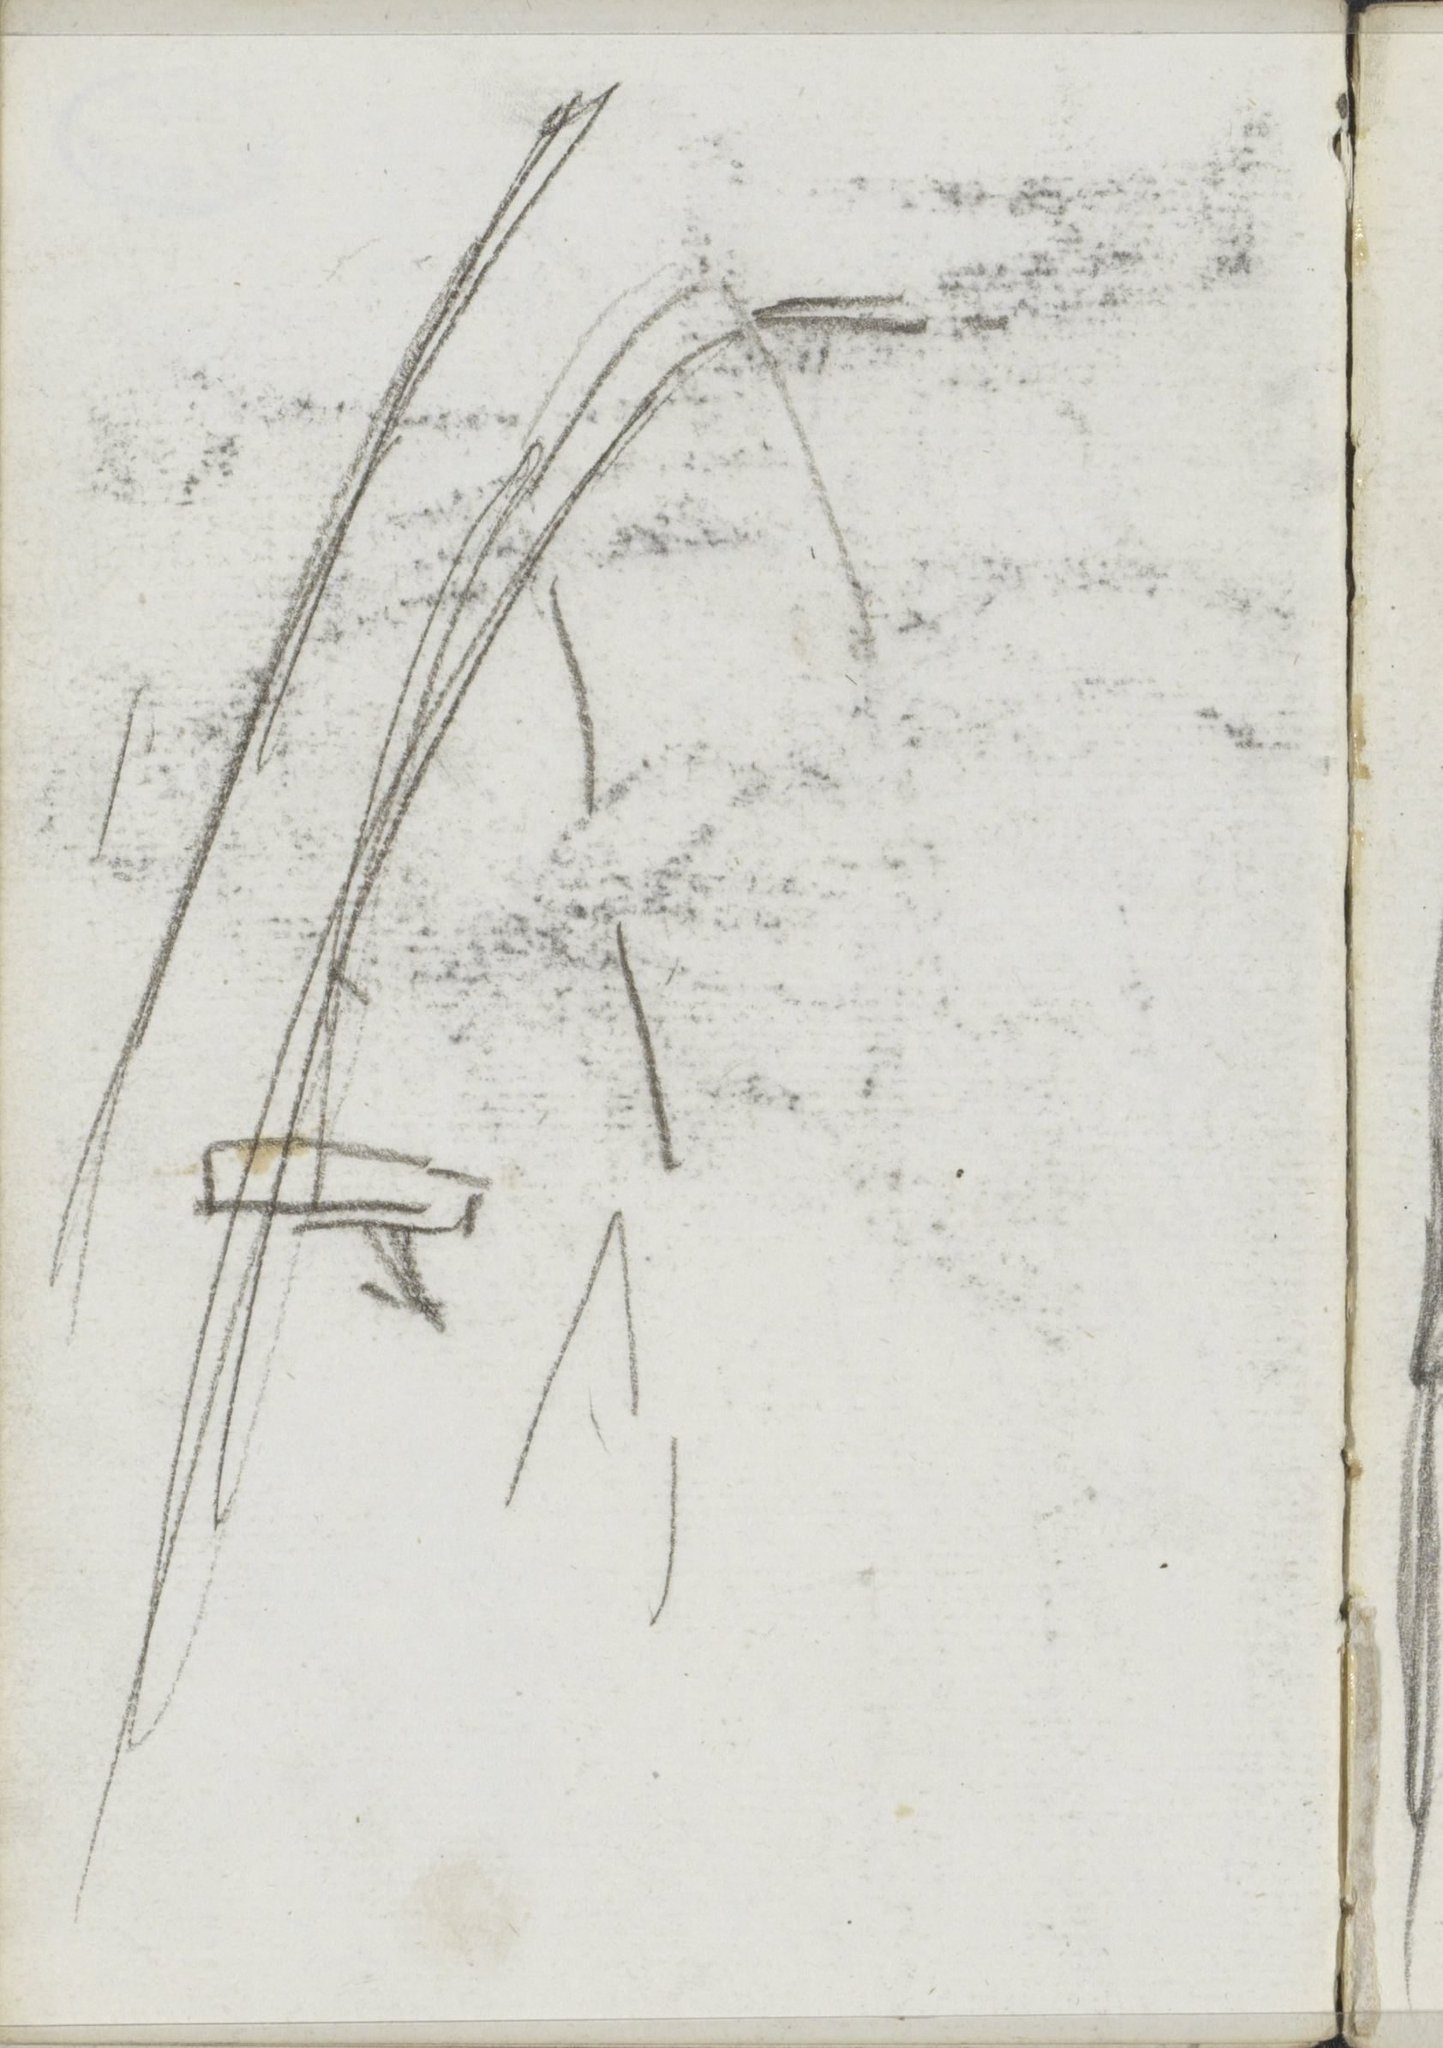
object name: sketchbook leaf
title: Studie, mogelijk van een weg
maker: george hendrik breitner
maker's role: draughtsman, painter, print maker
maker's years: 1857-1923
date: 1891-1894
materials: chalk, paper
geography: amsterdam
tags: road, path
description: Pagina 17 uit een schetsboek met 15 bladen.